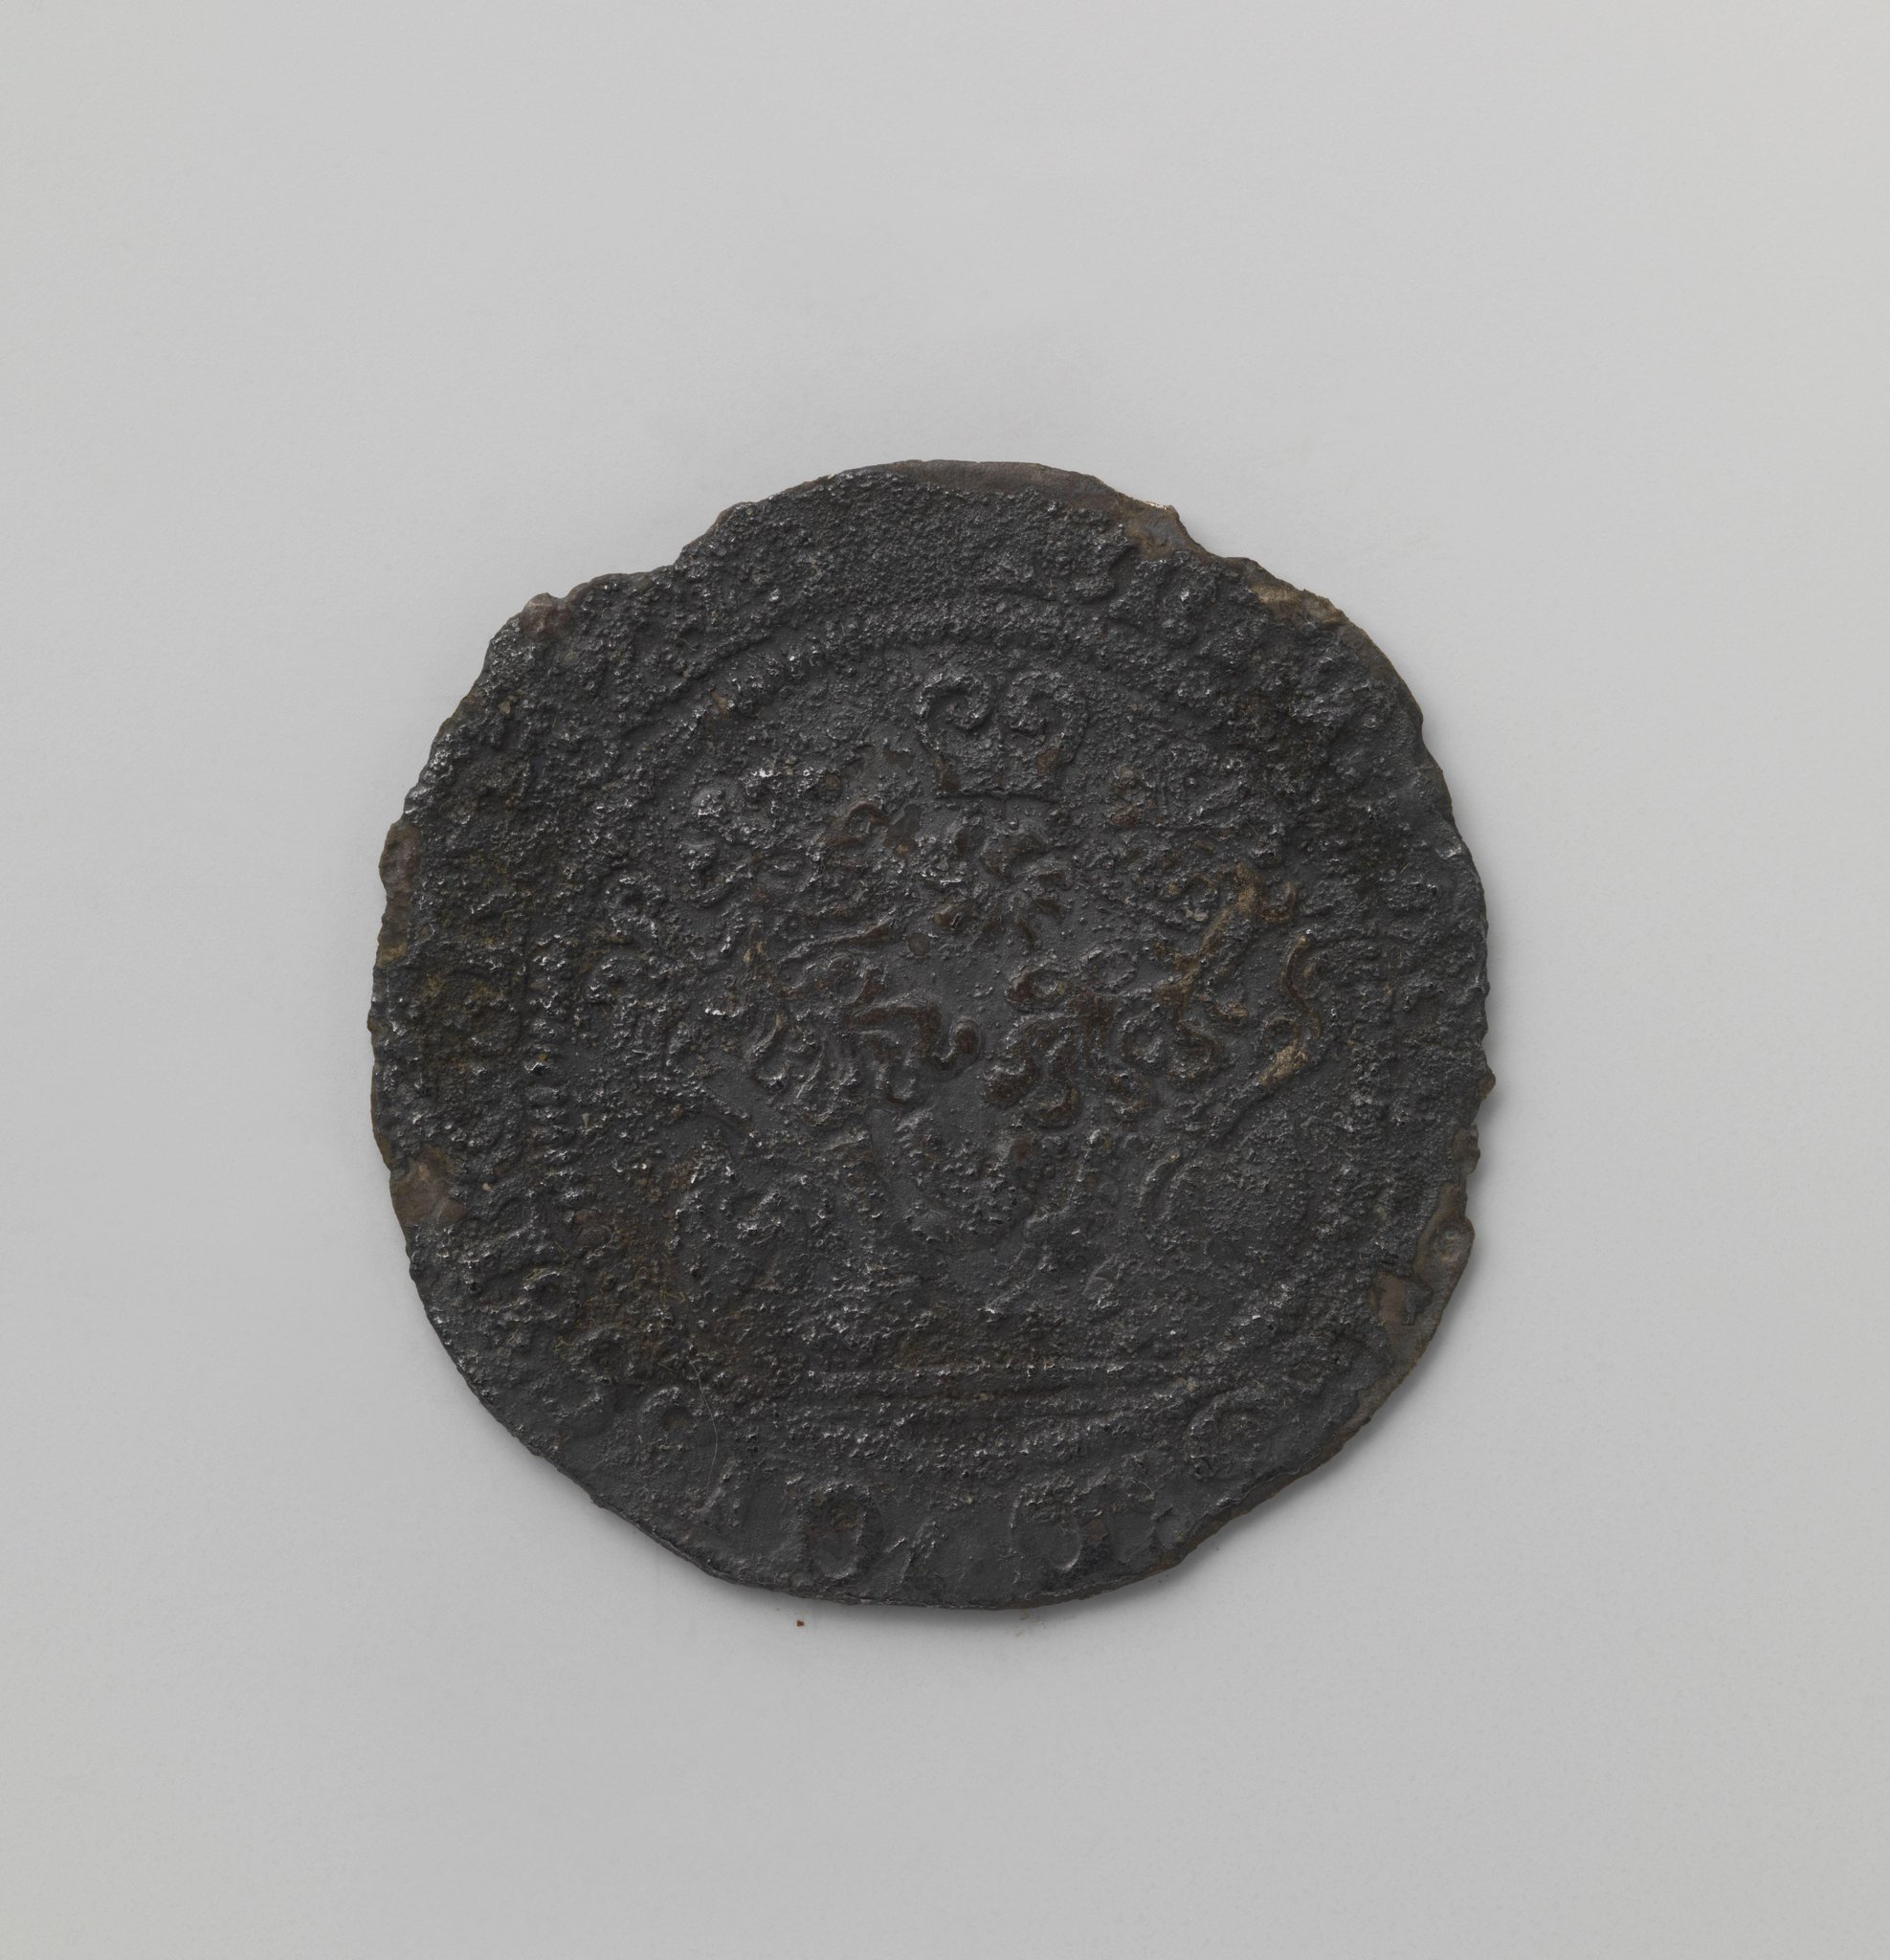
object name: coin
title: Dubbel vuurijzer uit Brabant van Maria van Bourgondië, 1478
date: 1478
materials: silver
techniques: striking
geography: antwerp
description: Zilveren munt. Voorzijde: twee naar elkaar toegewende zittende leeuwen. Daarboven vuurijzer. Keerzijde: wapenschild op een kort gebloemd kruis. Jaartal in omschrift.